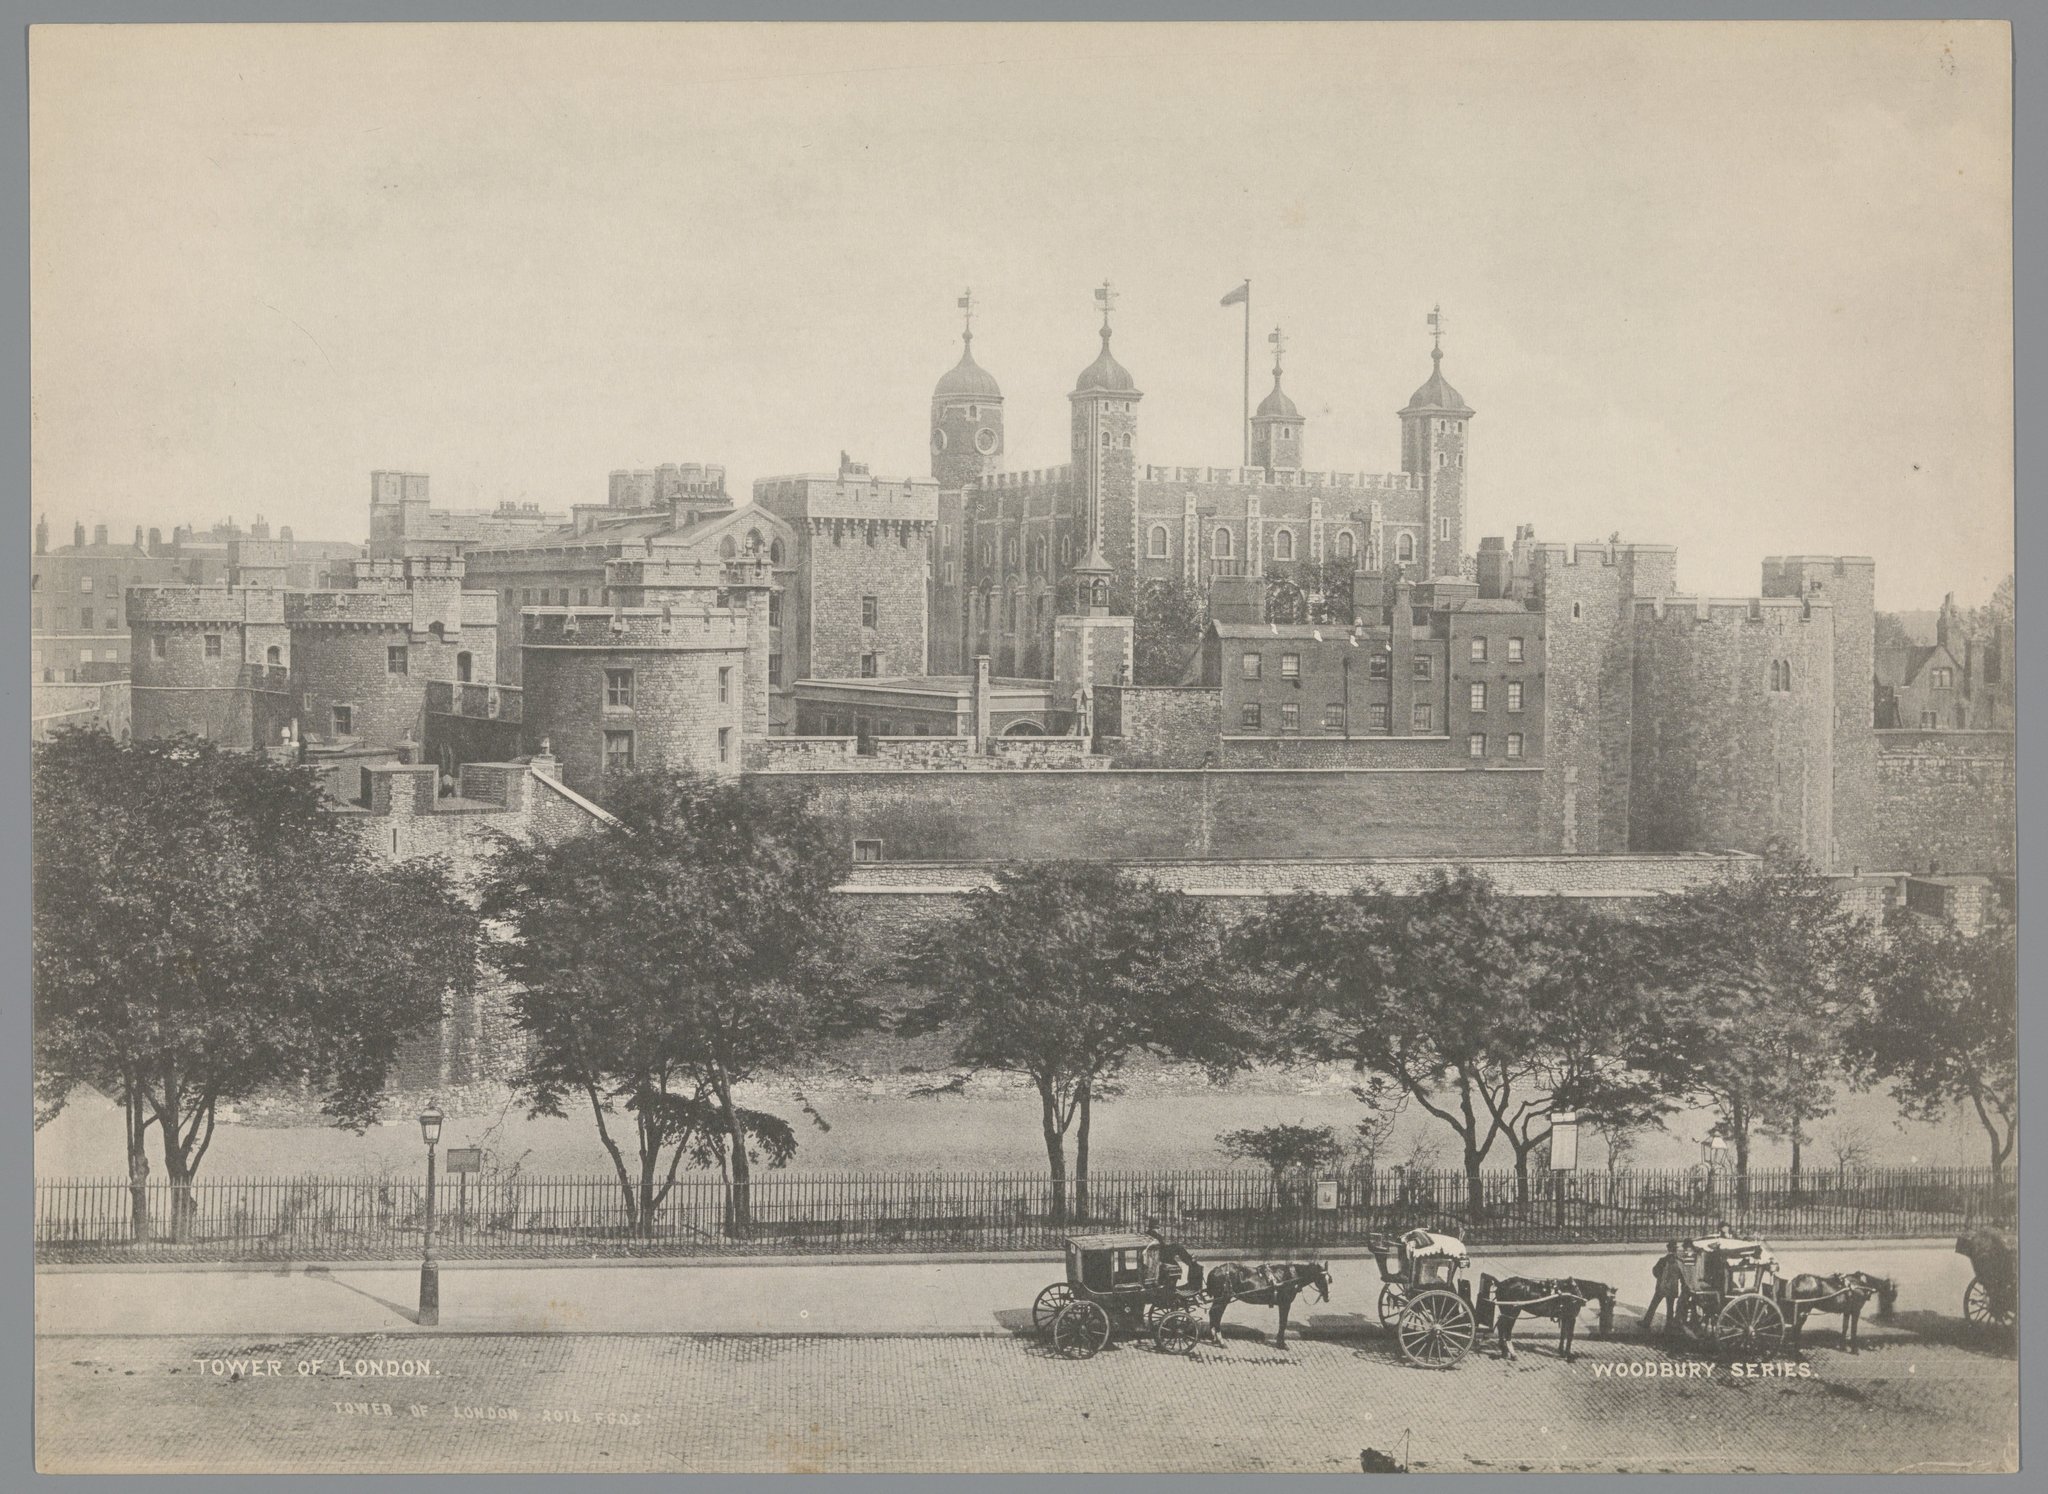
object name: print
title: Stadsgezicht van Londen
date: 1860-1915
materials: paper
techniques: photograph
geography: united kingdom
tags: tower of london